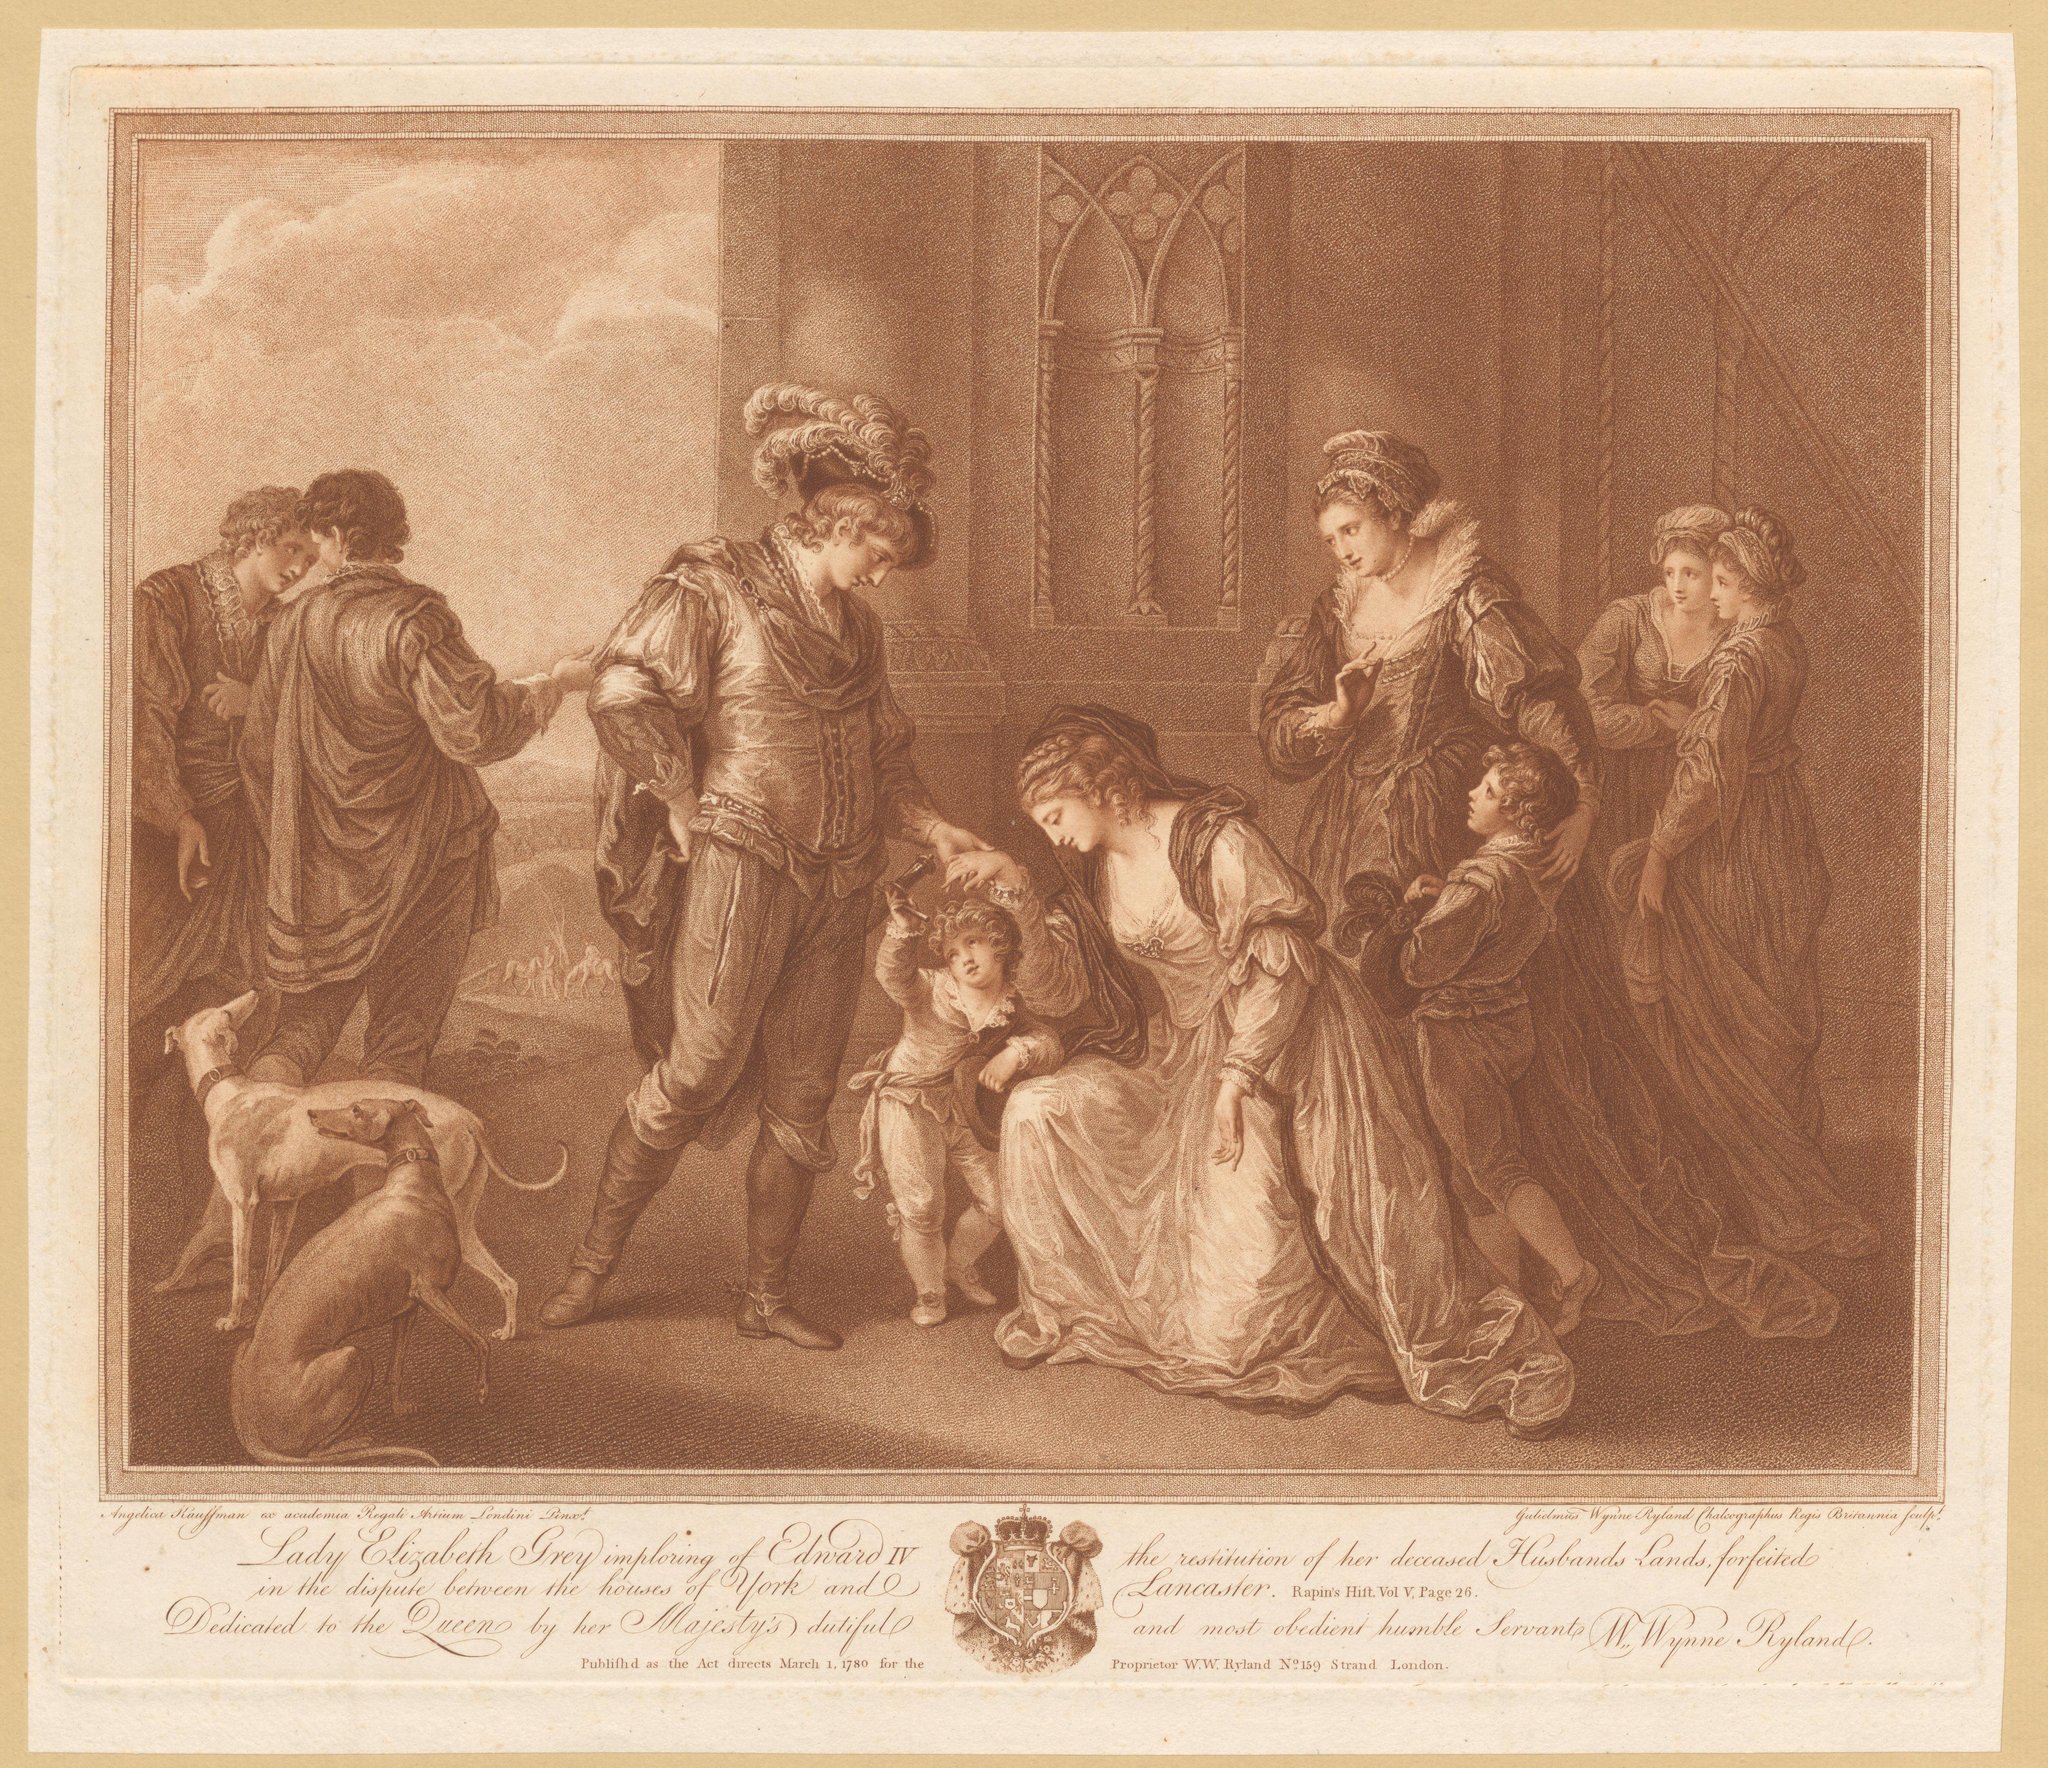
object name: print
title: Elizabeth Woodville geknield voor Eduard IV, koning van Engeland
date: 1780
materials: paper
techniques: etching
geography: london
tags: london, second marriage (of widow or widower), historical persons, queen, king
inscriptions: : ‘Lady Elizabeth Grey imploring of Edward IV the restitution of her deceased Husband Lands forfeited in the dispute between the houses of York and Lancaster.’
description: Gebaseerd op het verhaal over Koning Eduard I in: Rapin, Paul de. History of England. [Vertaald uit het Frans door] Nicolas Tindal. Londen: s.n., [1727], dl. 5, p. 26.